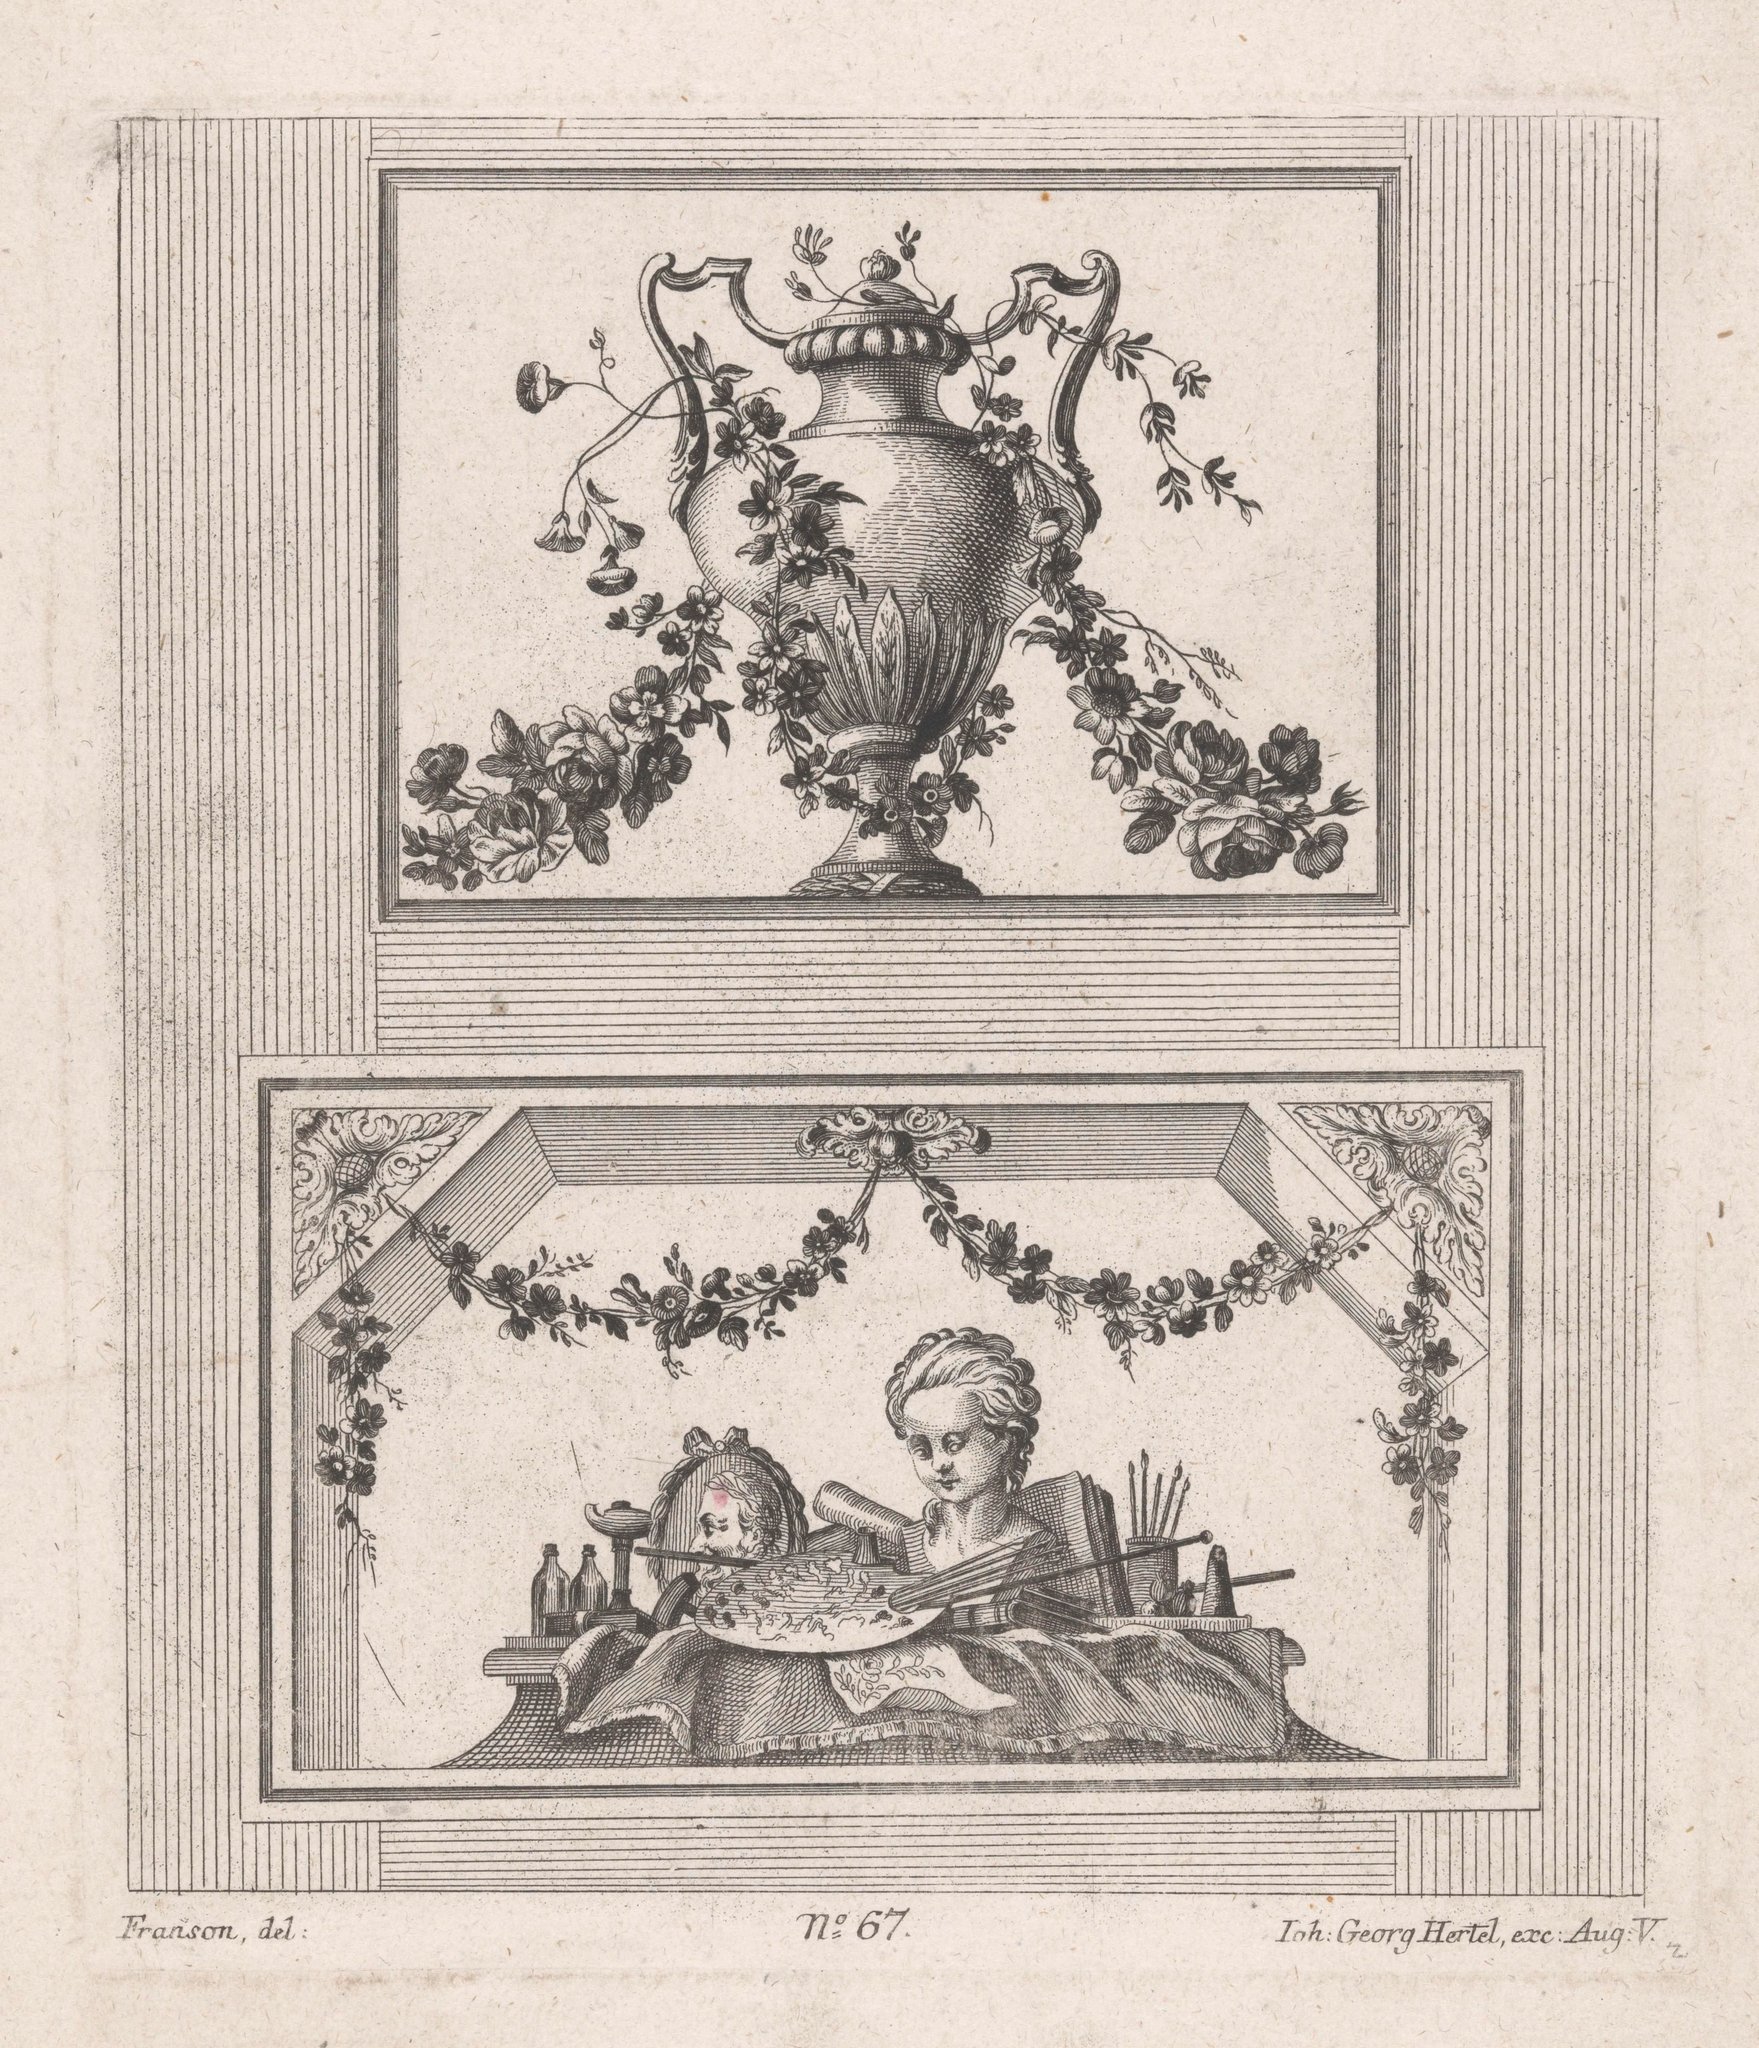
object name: ornament print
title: Vaas en schildersattributen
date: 1746-1775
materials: paper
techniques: etching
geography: augsburg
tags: vase ~ ornament, tools, implements of painter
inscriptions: collector's mark: Lugt 2228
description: Een geornamenteerde vaas met guirlandes in een rechthoekige omlijsting. Daaronder een paneel met guirlandes en schildersattributen zoals een buste, een palet, penselen en een doek. Uitgeversnummer 67.